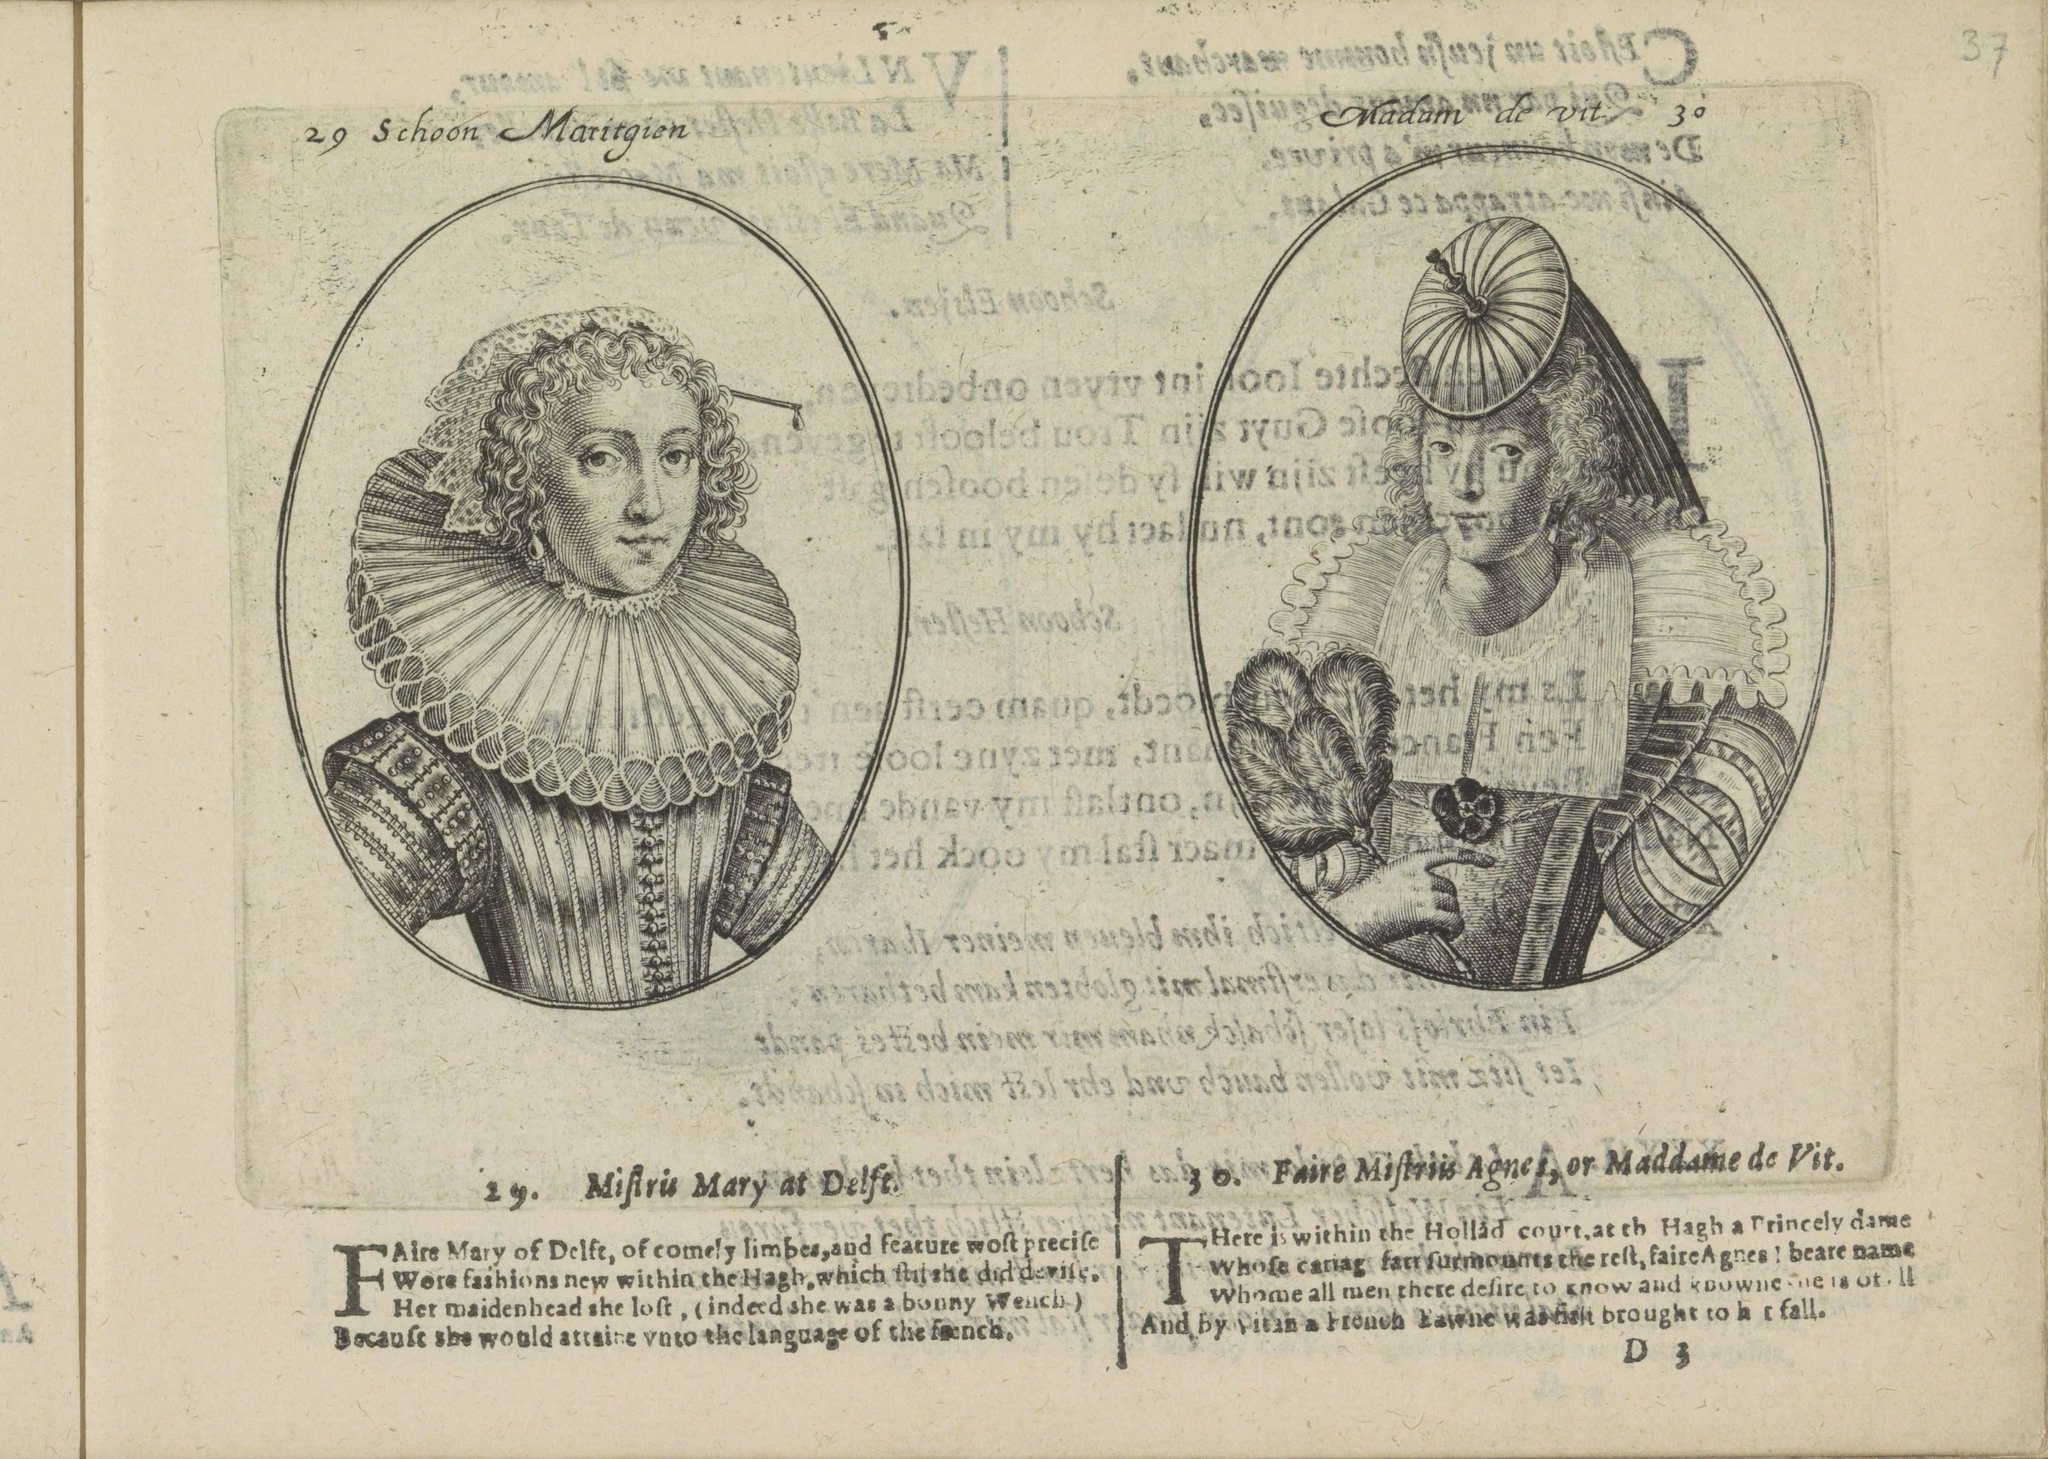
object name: album leaf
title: Schoon Maritgien / Madam de vit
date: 1635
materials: paper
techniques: engraving, letterpress printing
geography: utrecht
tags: herding, herdsman, herdswoman, shepherd, shepherdess, cowherd, etc.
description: Twee voorstellingen op een albumblad. Links de courtisane genaamd Schone Maritje uit Delft en rechts Madame Agnes de Vit uit Den Haag. Daaronder twee kwatrijnen in het Engels. Het blad maakt deel uit van een album.